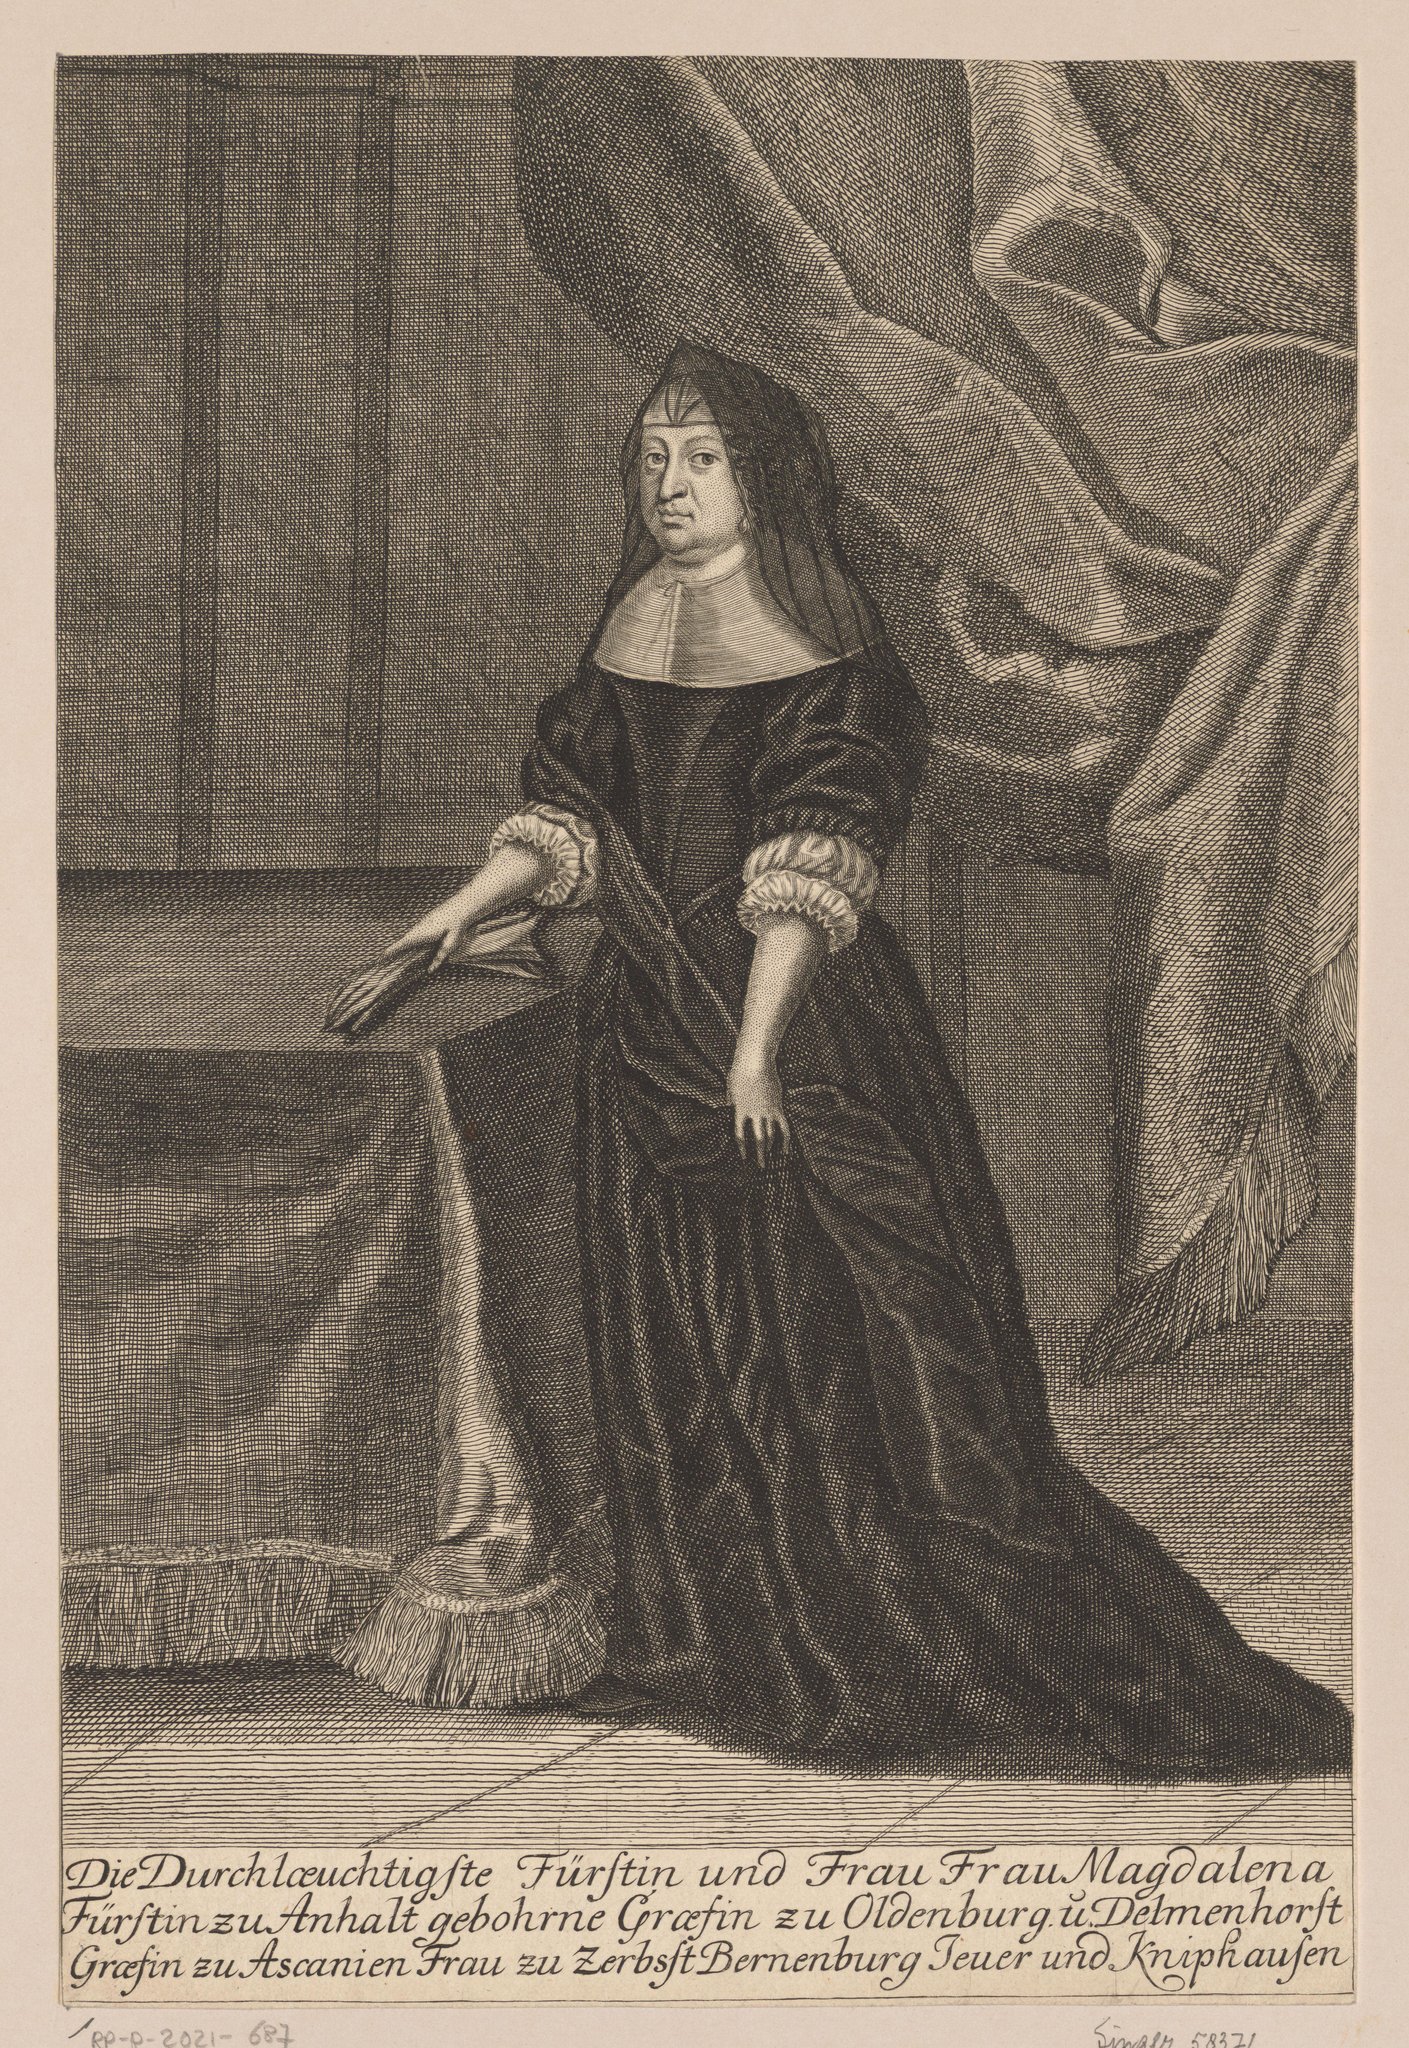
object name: print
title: Portret van Magdalena van Oldenburg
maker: Anonymous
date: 1600-1700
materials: paper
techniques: engraving, etching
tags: historical persons